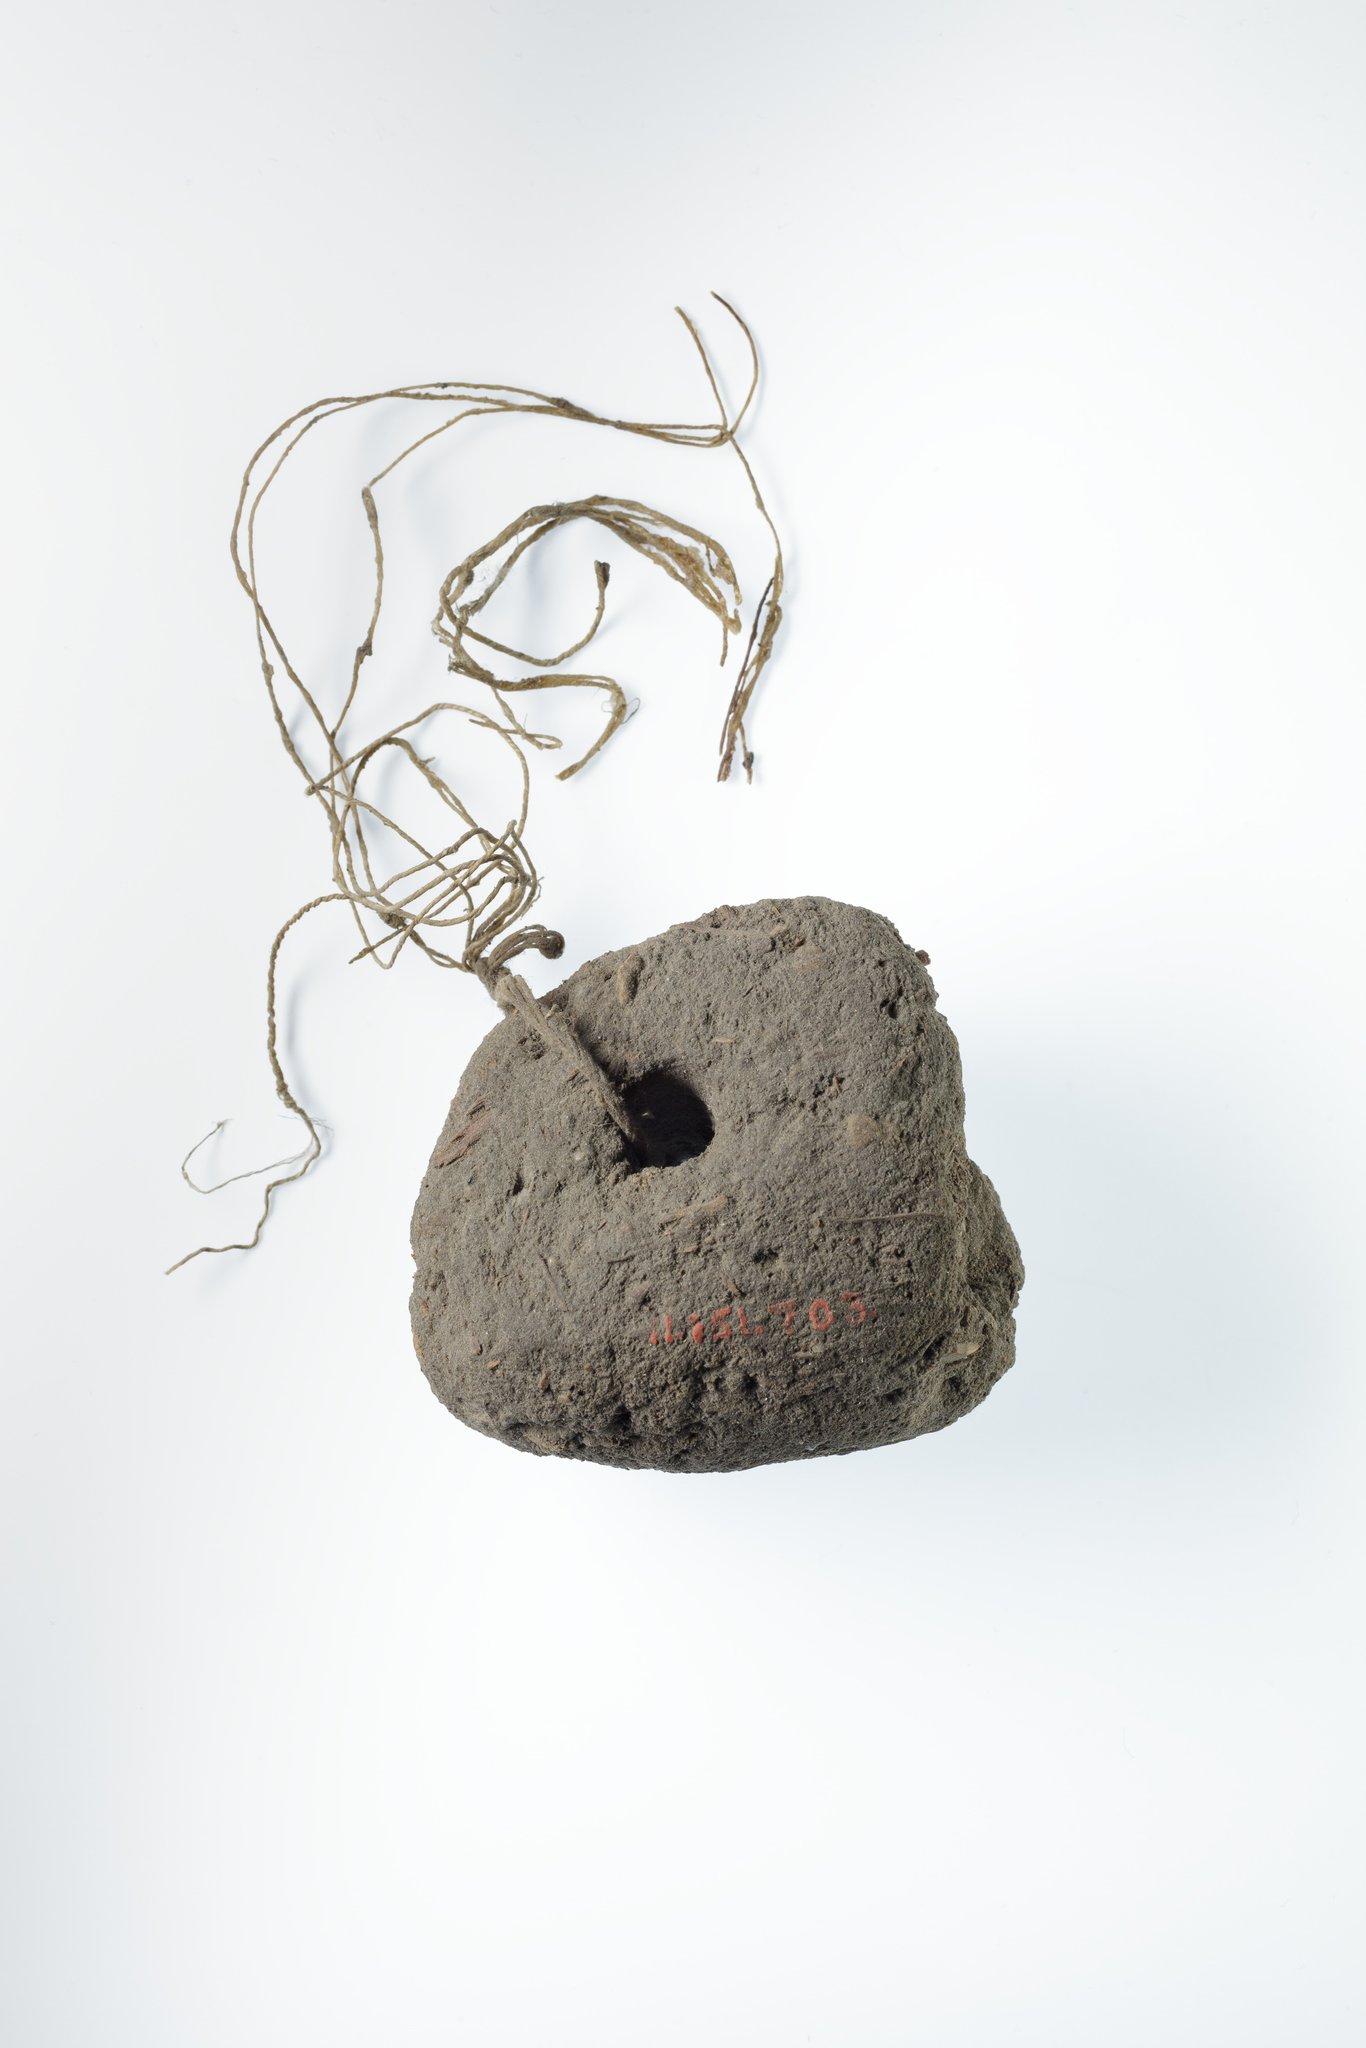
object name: weight, fragment, loom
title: Fragment of loom weight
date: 1295-1070 BCE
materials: mud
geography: egypt